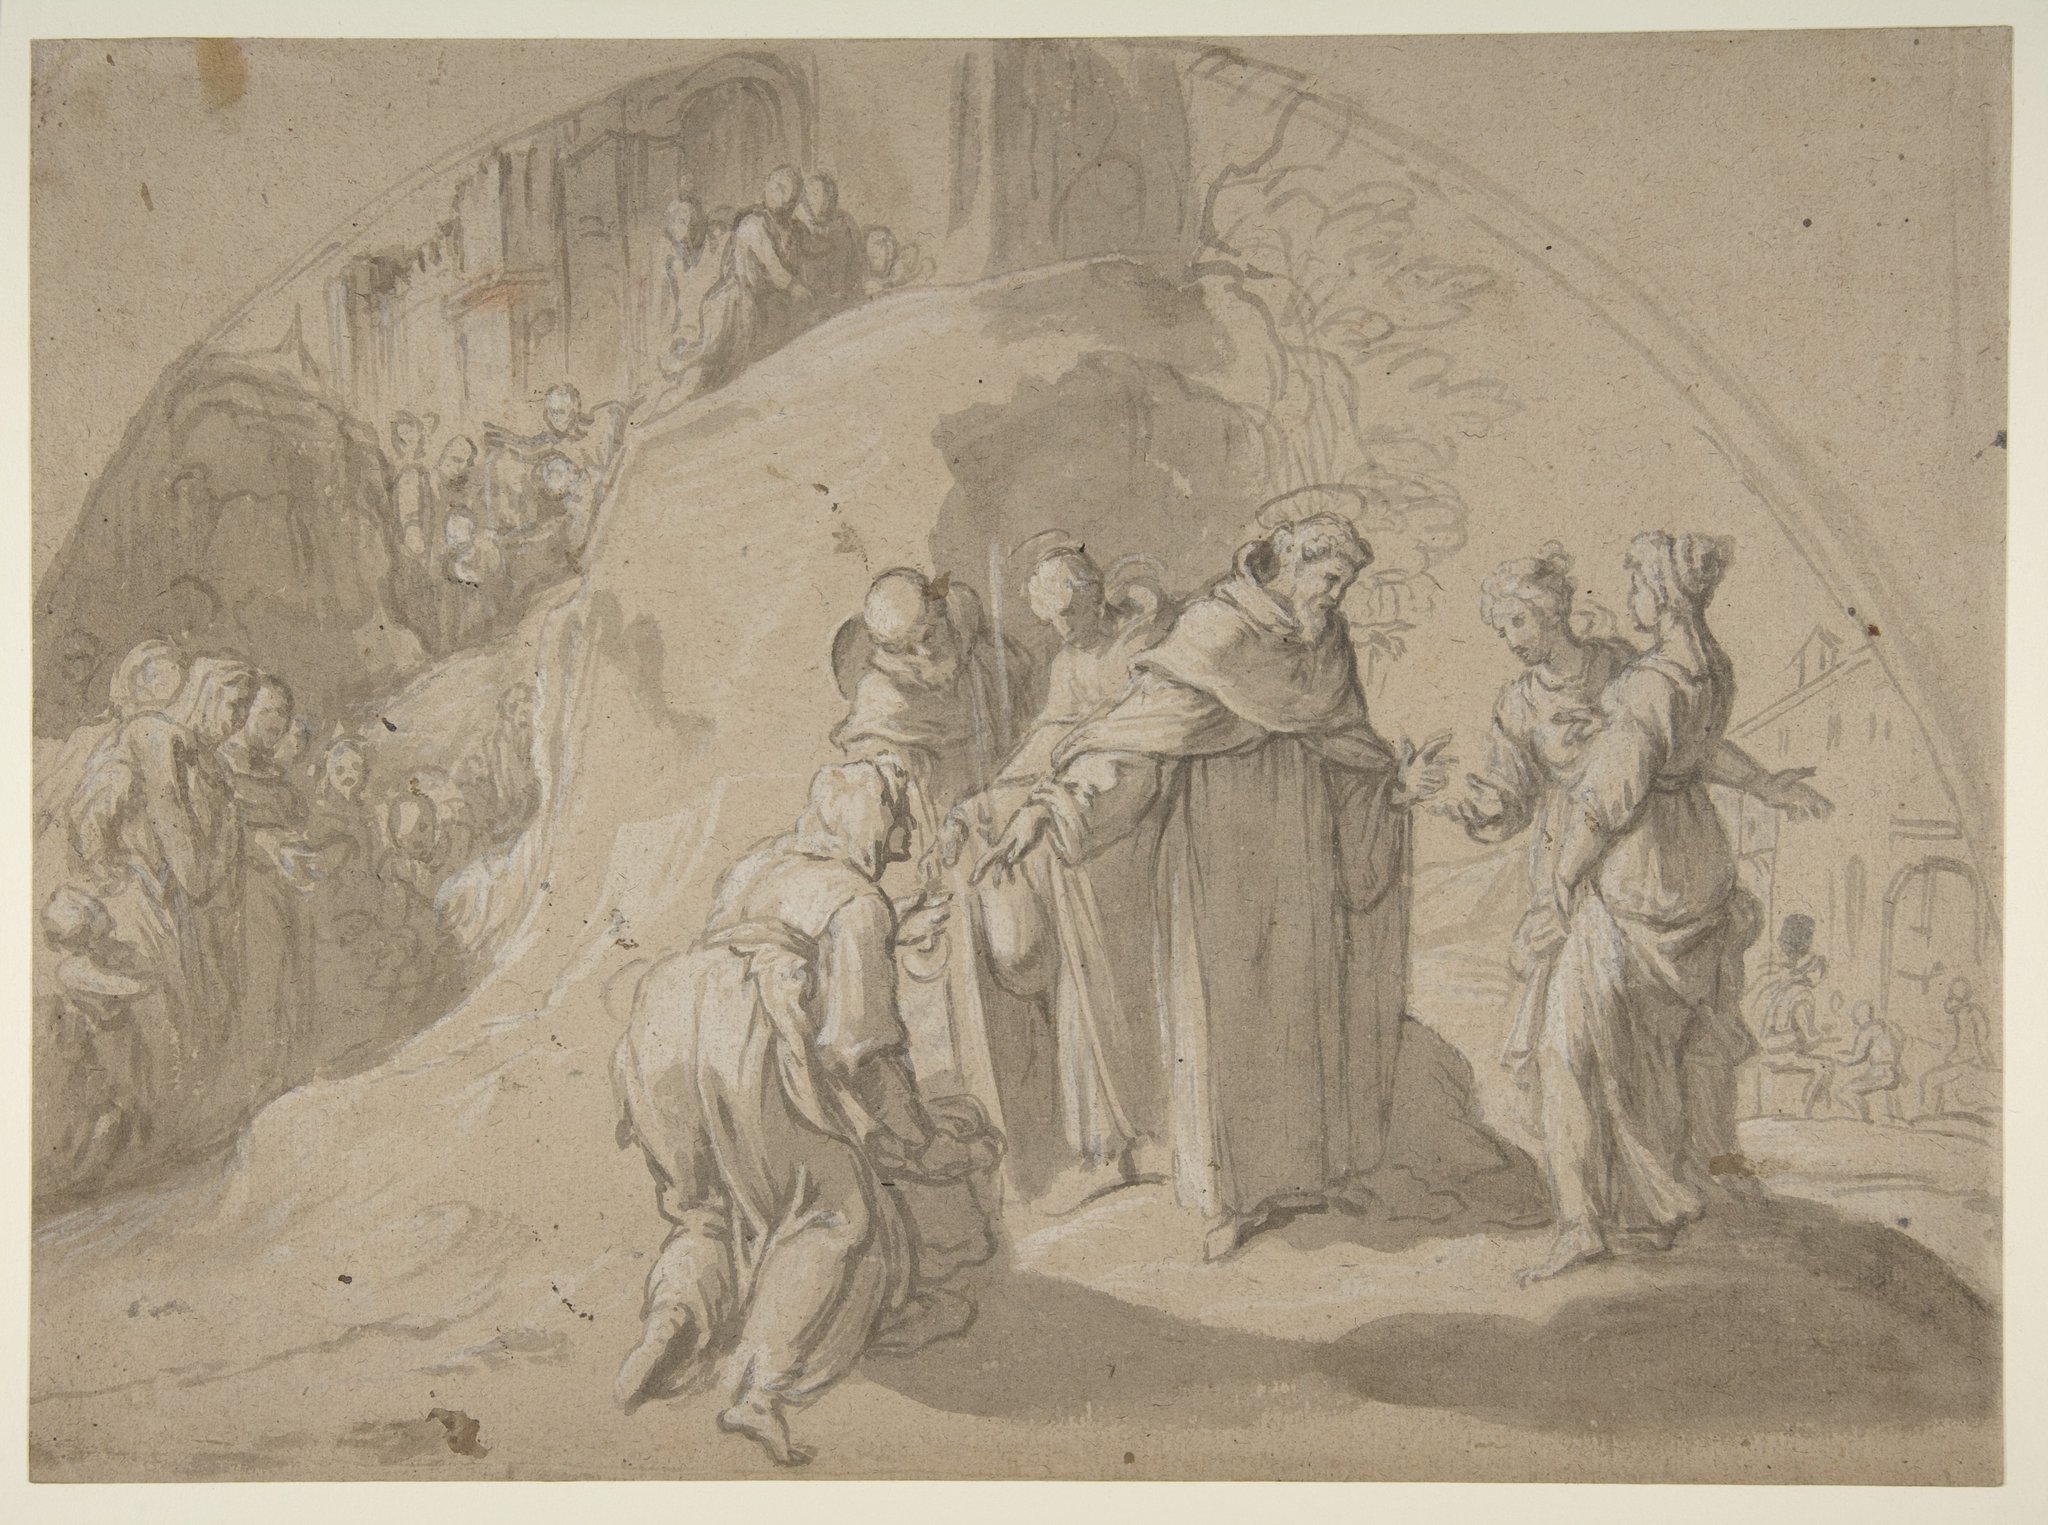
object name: drawing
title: Saint Philip Benizi Converting Two Wicked Women at the City of Todi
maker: bernardino poccetti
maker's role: artist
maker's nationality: italian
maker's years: 1548-1612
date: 1608-1609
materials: gouache, paper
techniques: brush, highlighting, wash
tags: women,saints